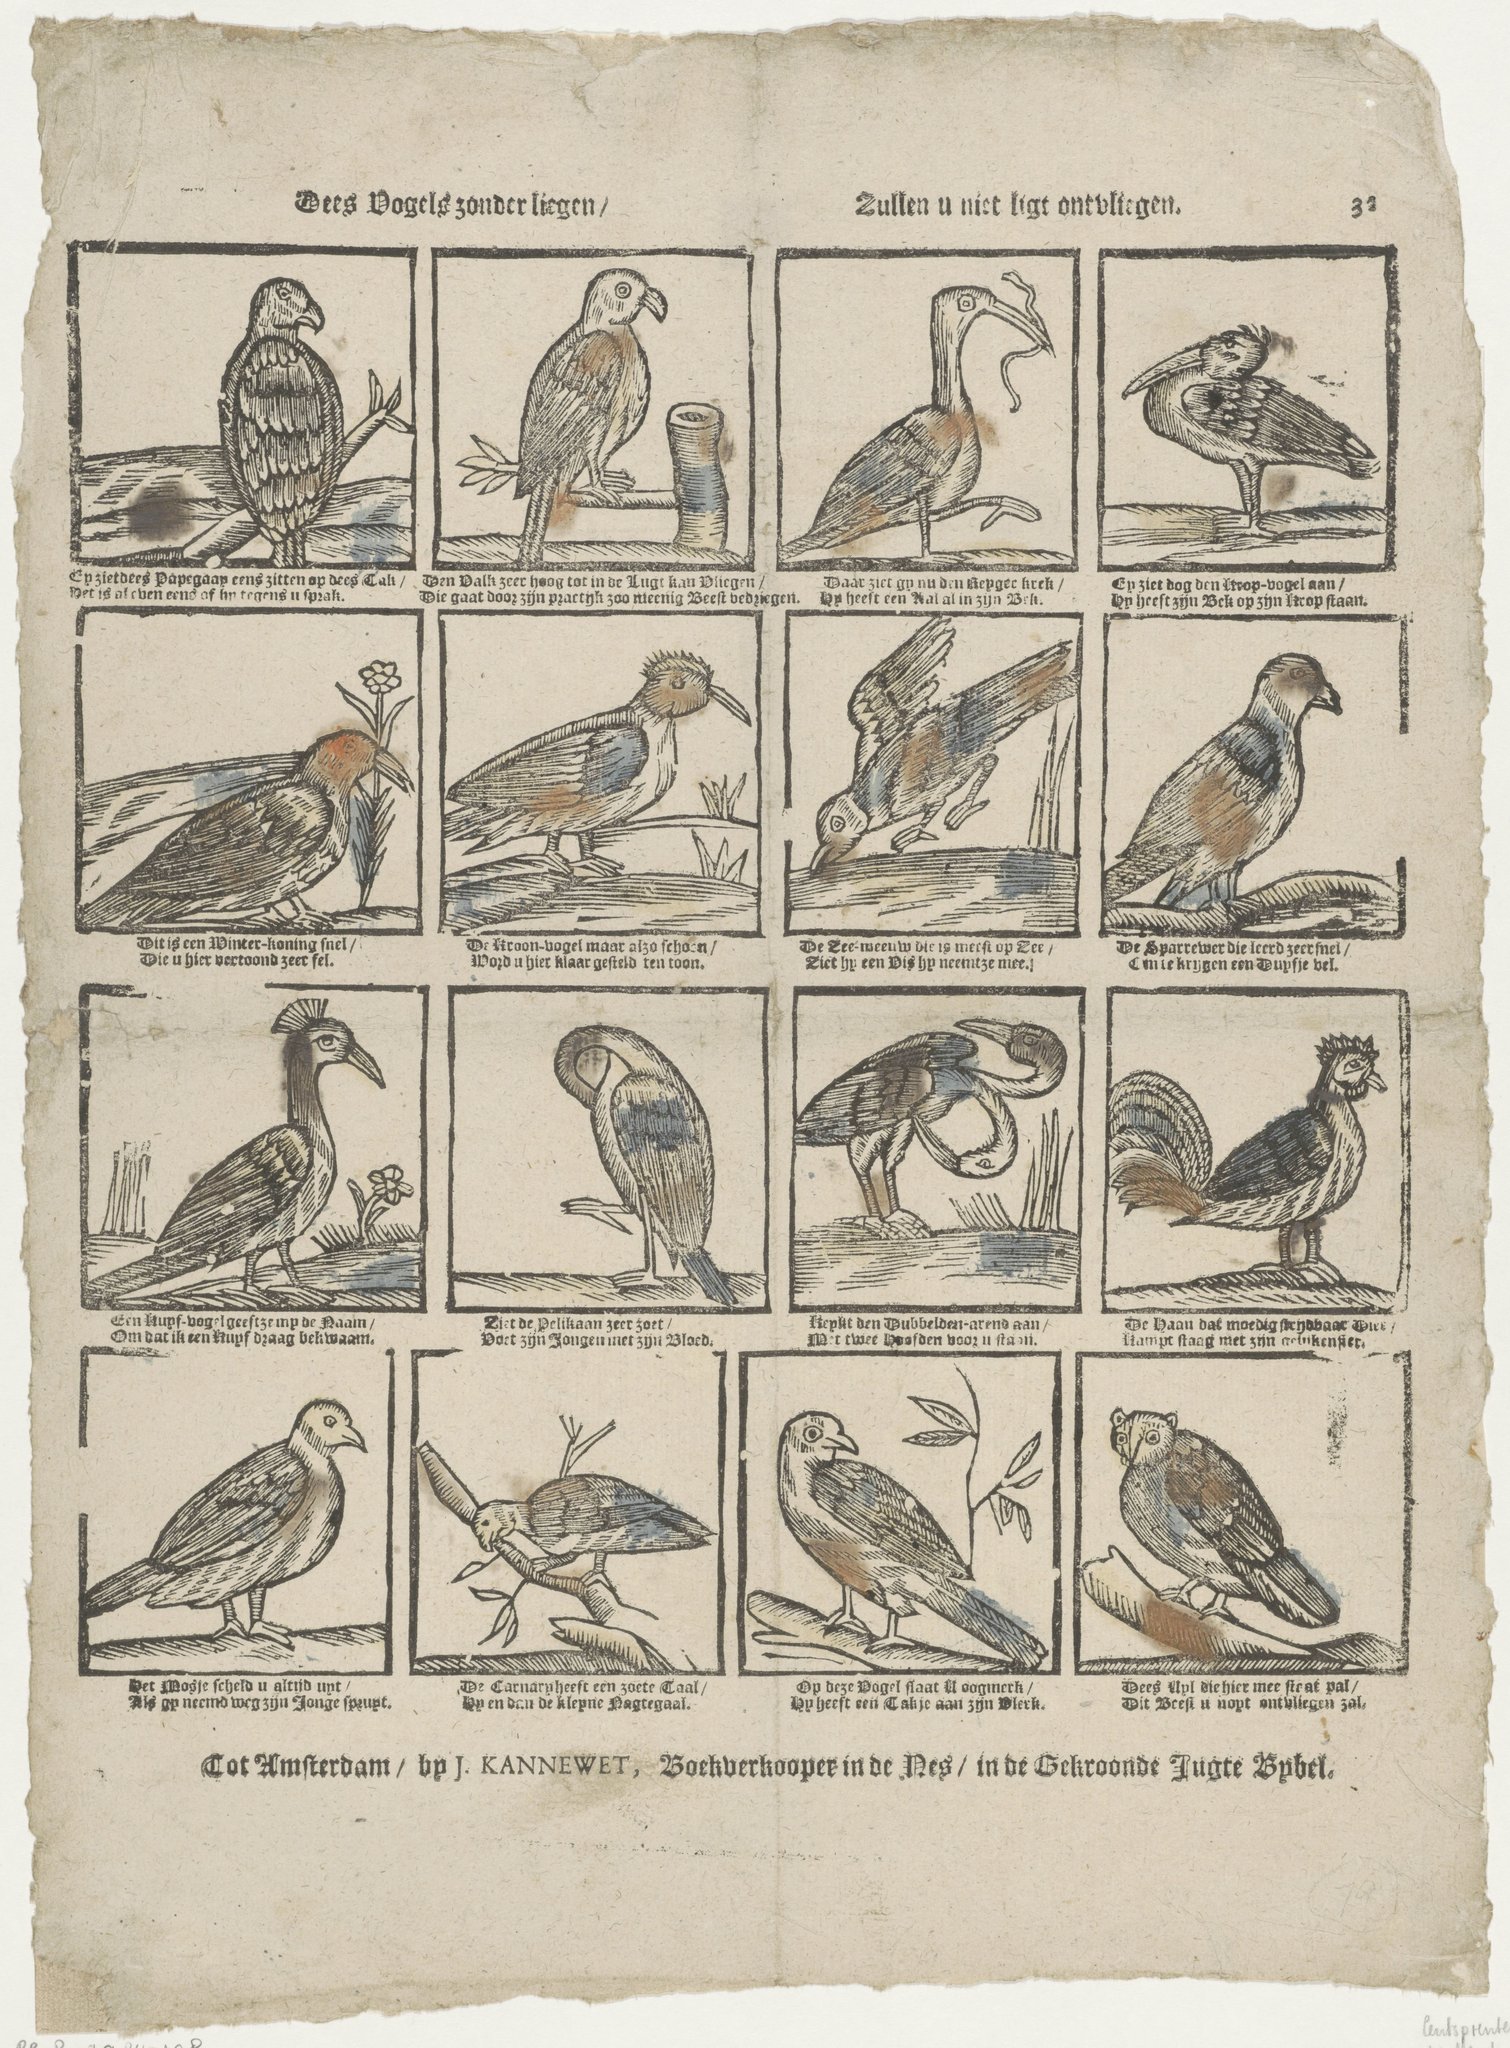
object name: popular print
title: Dees Vogels zonden/Zullen u niet ligt ontvliegen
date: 1725-1780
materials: paper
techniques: colour, letterpress printing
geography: amsterdam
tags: birds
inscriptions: collector's mark: Lugt 2228, collector's mark: Lugt 2760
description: Blad met 16 voorstellingen van vogels, zoals een papegaai, een valk en een pelikaan. Onder elke afbeelding een tweeregelig vers. Genummerd rechtsboven: 32.